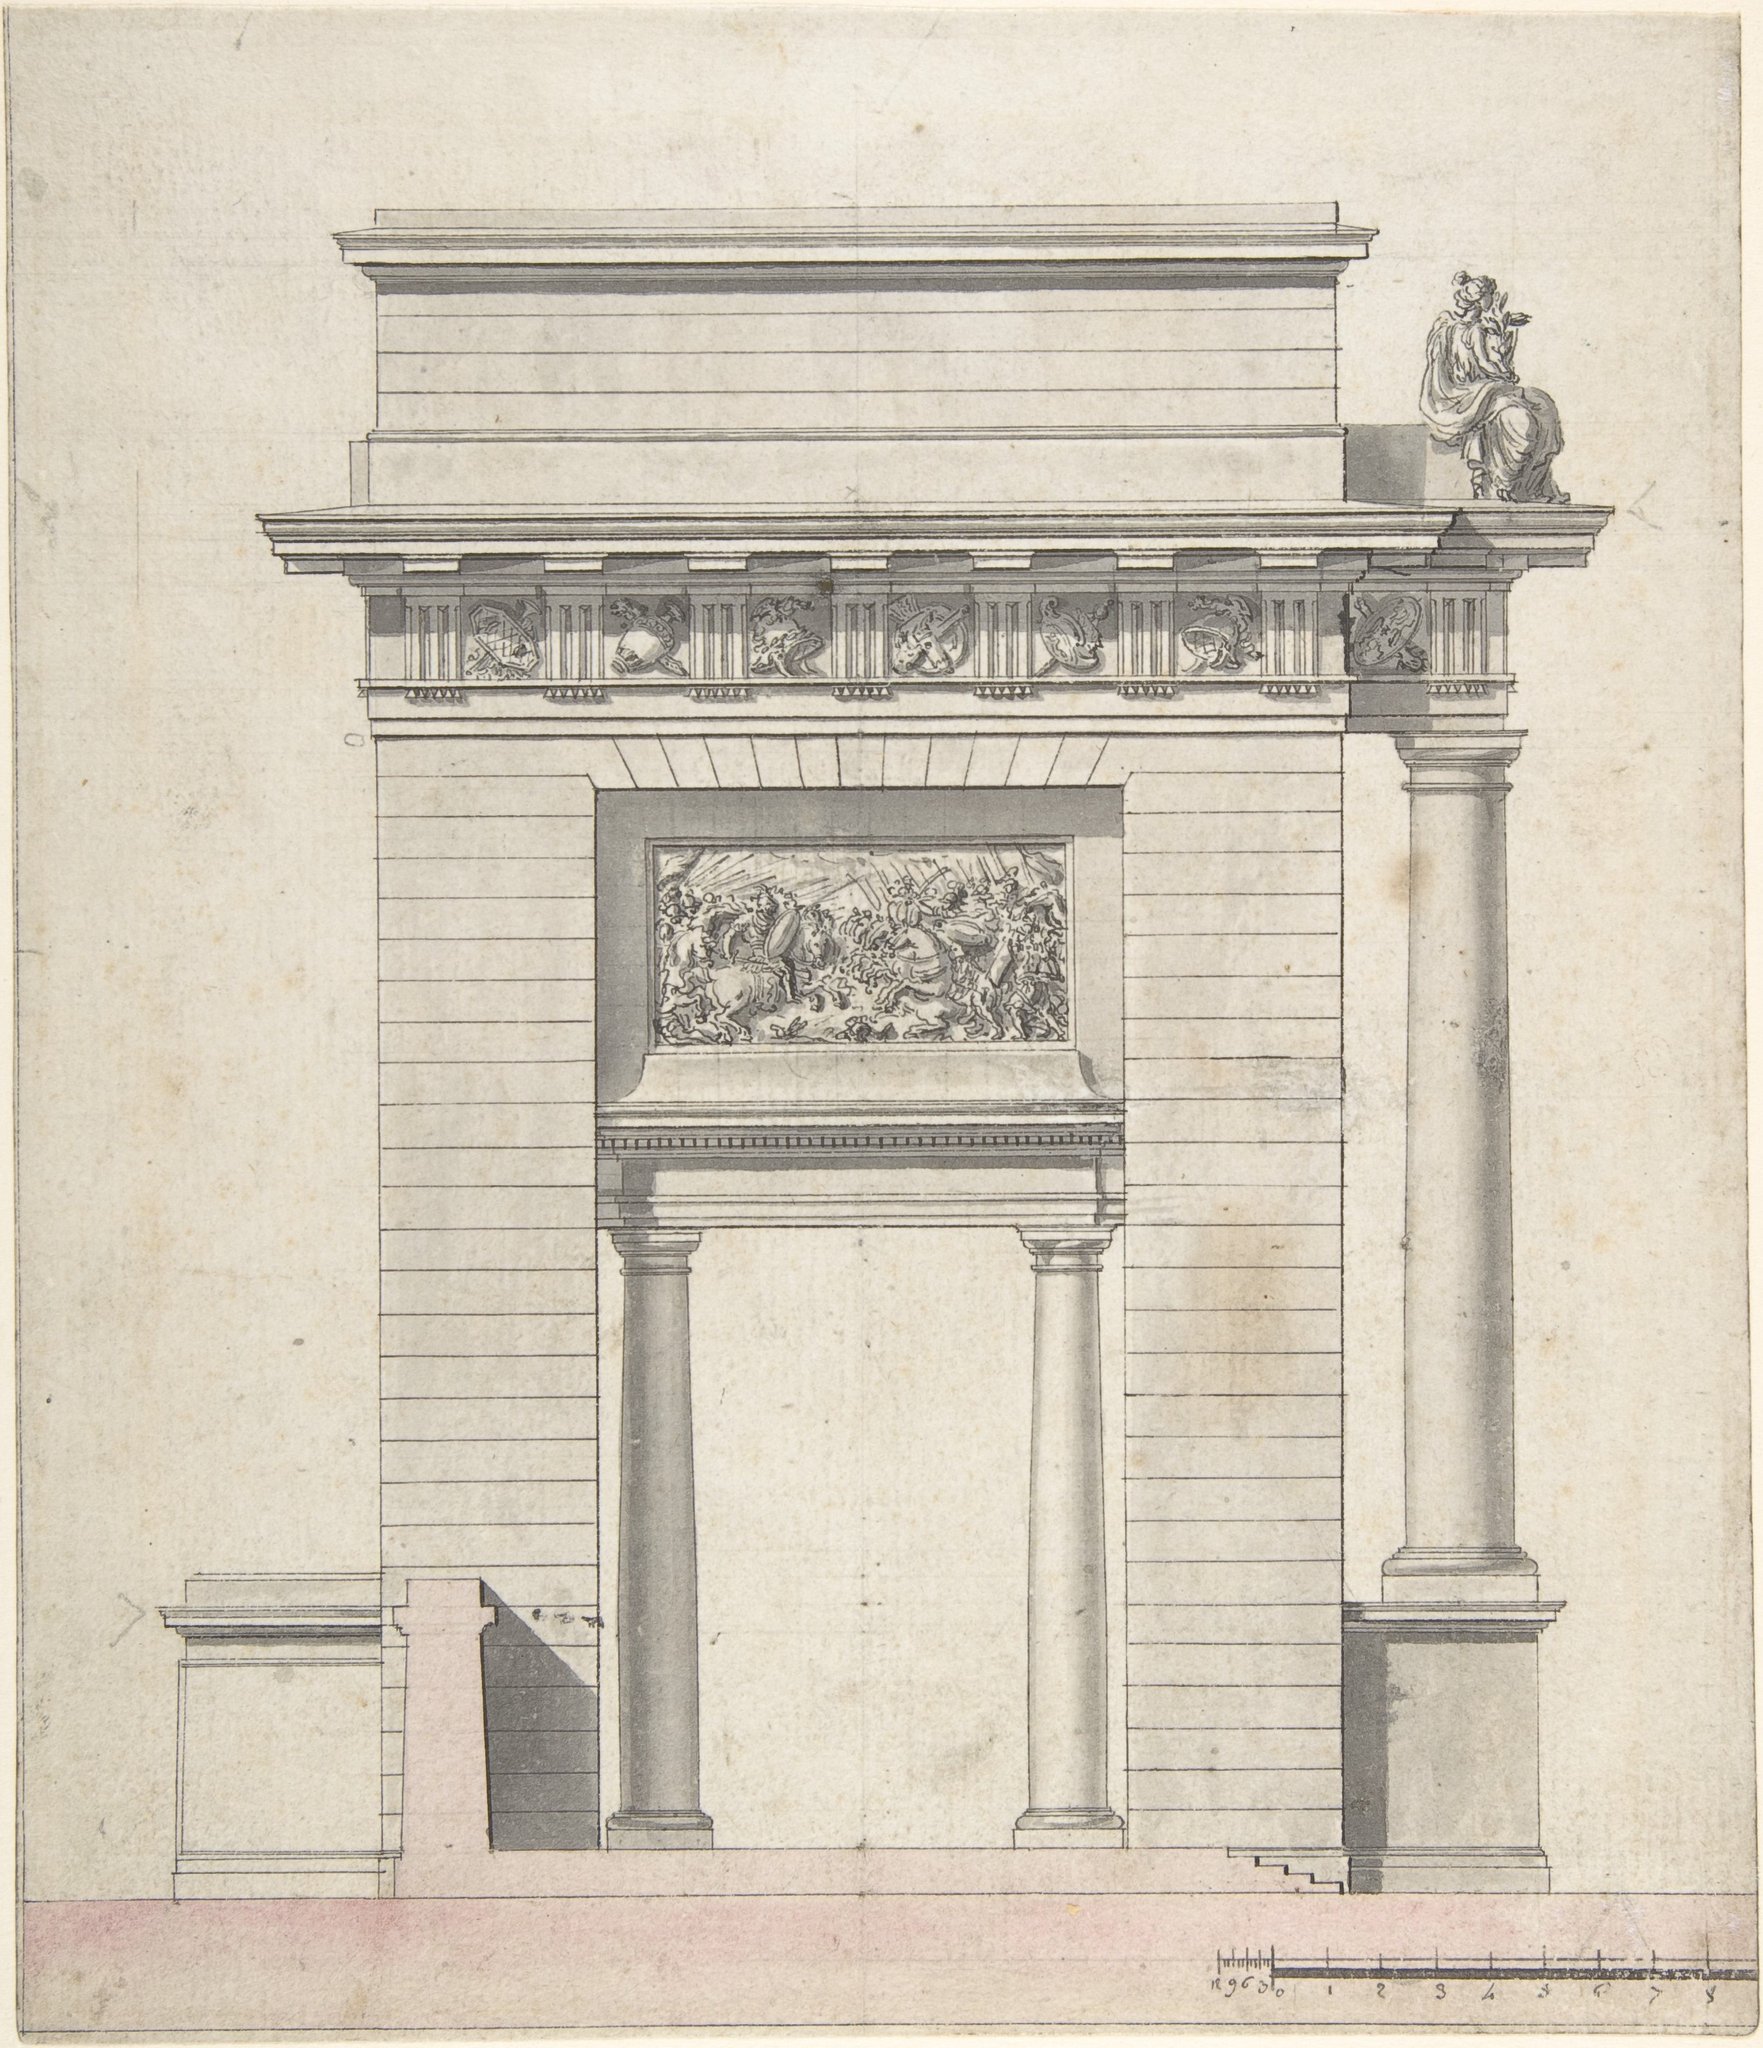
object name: drawing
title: Side Elevation of a Triumphal Arch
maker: anonymous, french, 18th century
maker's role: artist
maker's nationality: french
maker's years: 1700-1800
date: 1701-1800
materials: ink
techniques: brush, pen, wash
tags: architecture,arches,columns